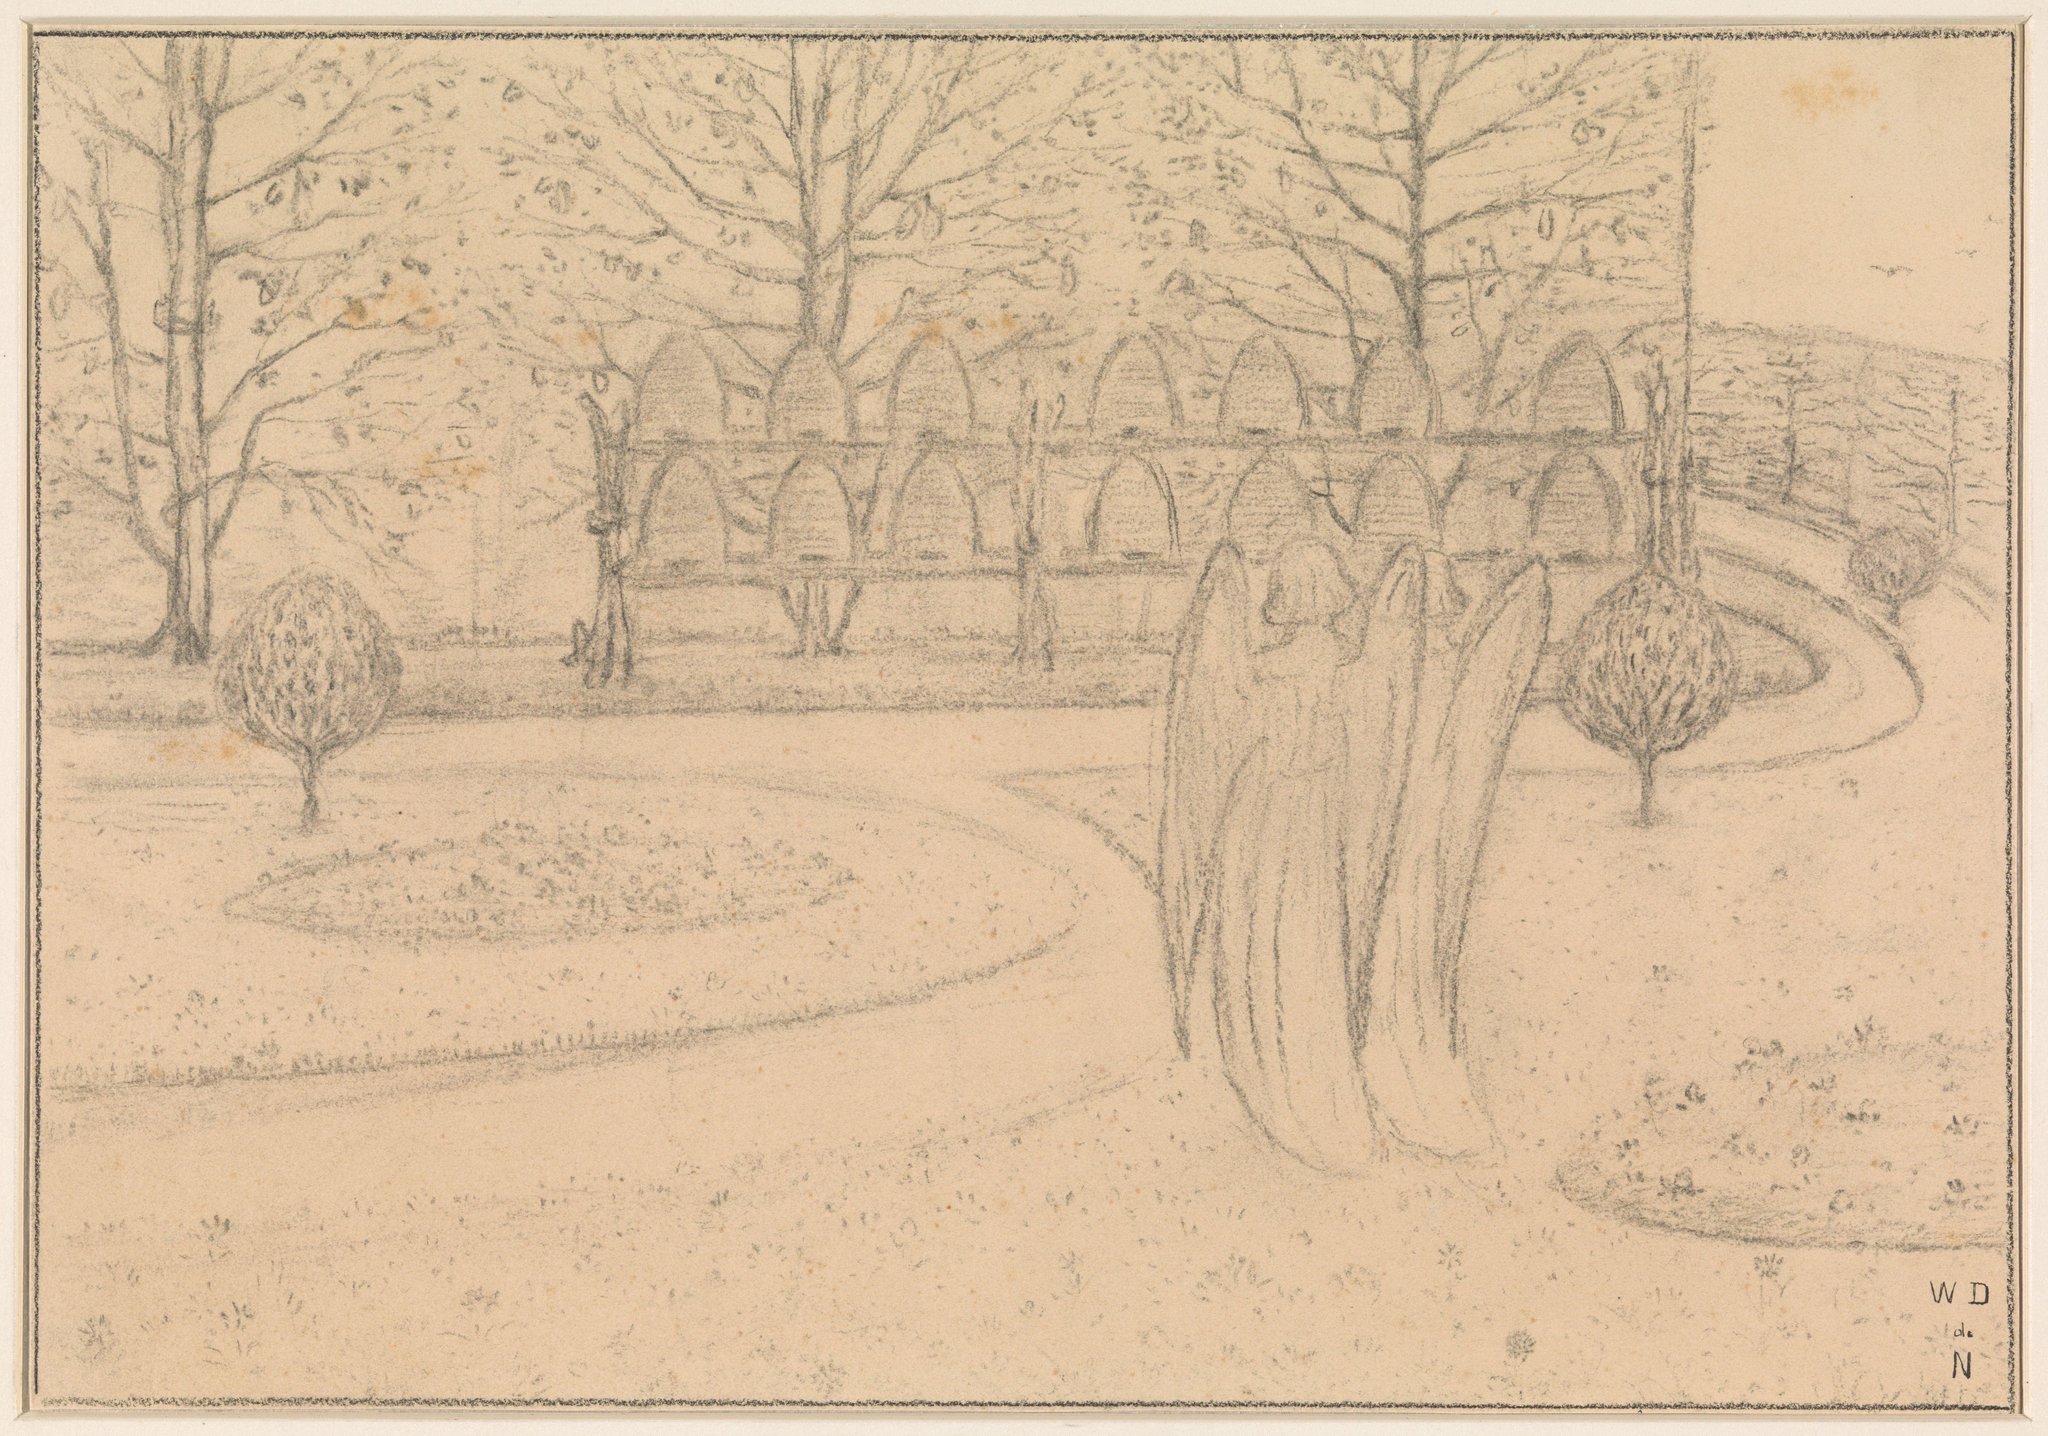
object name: drawing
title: La visite aux ruches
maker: william degouve de nuncques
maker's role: draughtsman, print maker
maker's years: 1867-1935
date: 1896-1900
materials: charcoal, paper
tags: bee-hive, lower angel(s)